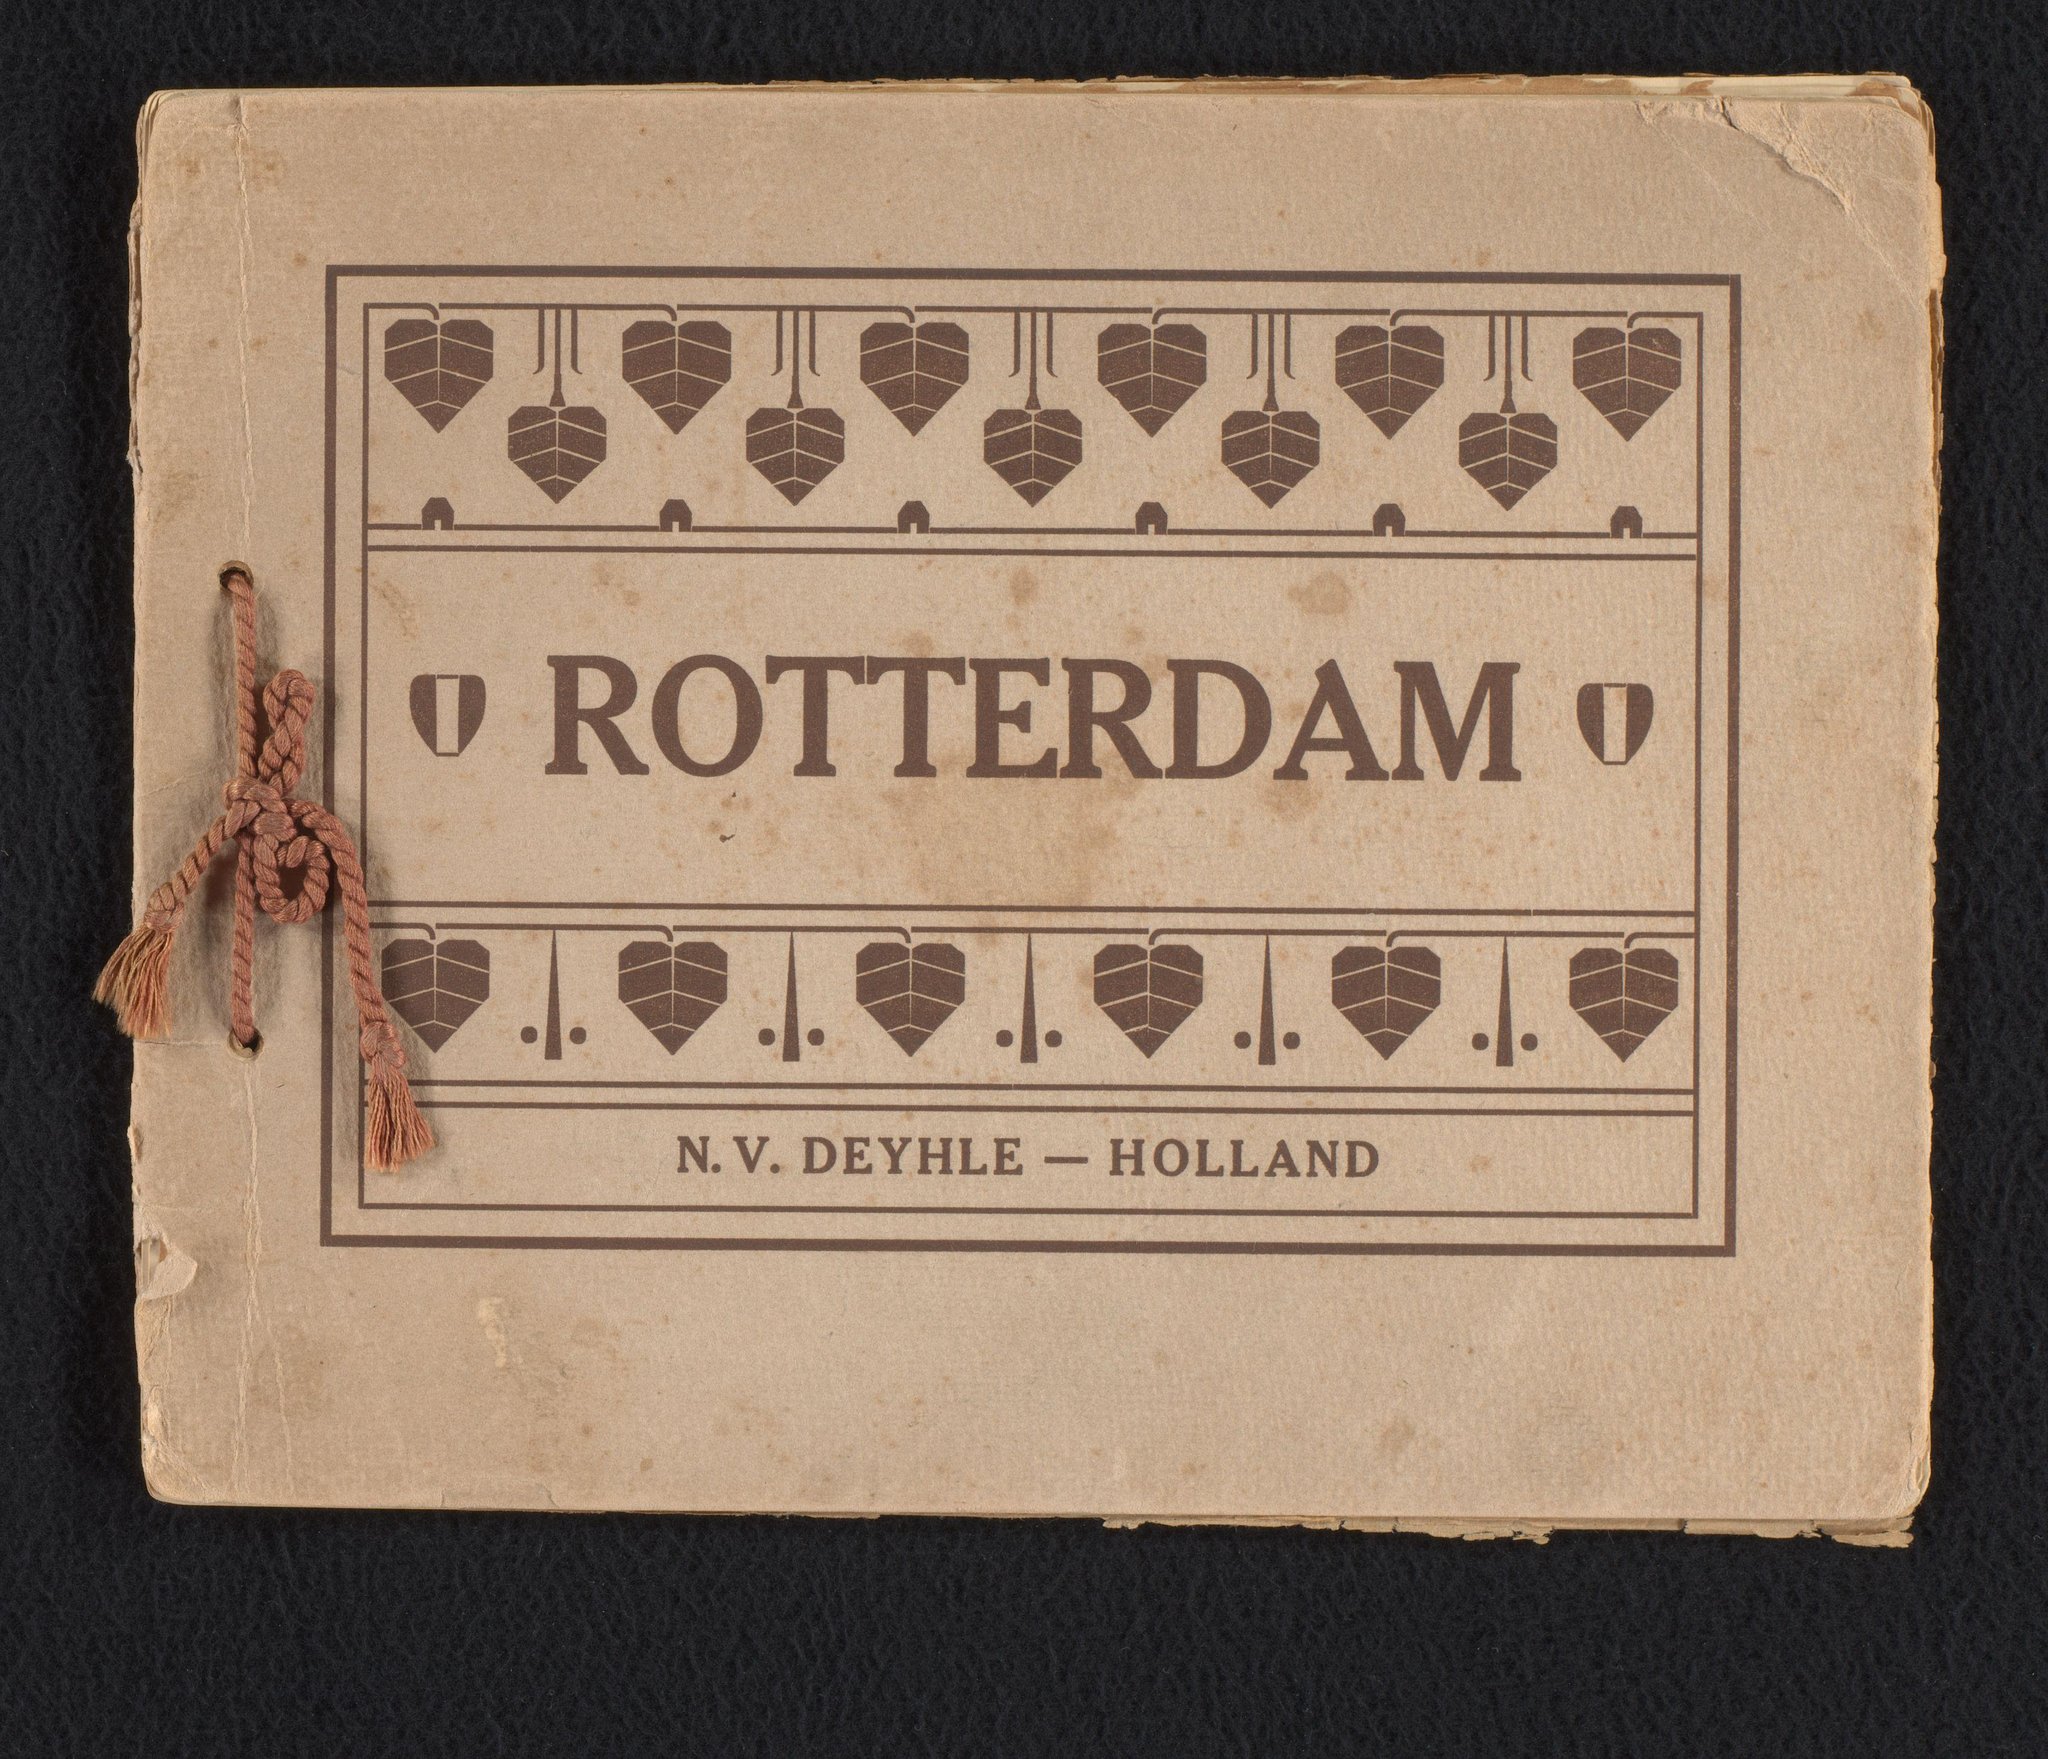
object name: photobook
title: Souveniralbum met gezichten op Rotterdam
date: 1905-1920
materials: paper, textile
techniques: photograph, lithograph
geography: rotterdam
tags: harbour, city-view in general; 'veduta', street, rotterdam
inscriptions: : ‘.’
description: Boek met twaalf lichtdrukken van stadsgezichten in Rotterdam. De fotograaf is anoniem. Was te koop als souvenir van de stad.